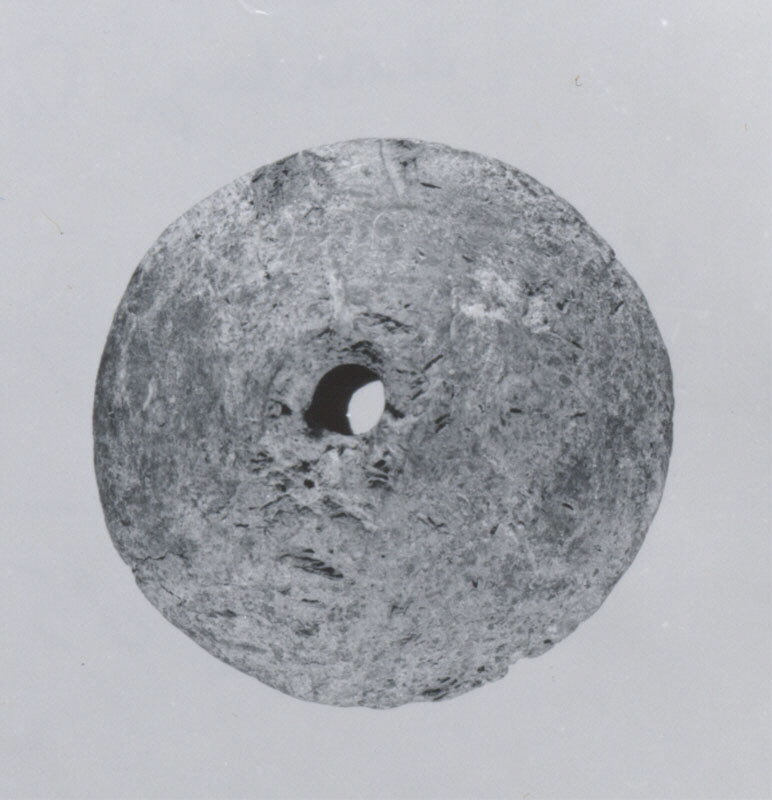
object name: whorl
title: Spindle whorl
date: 6000-5001 BCE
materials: ceramic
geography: iran